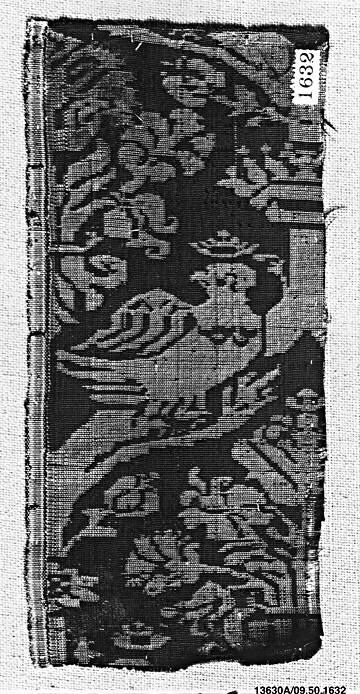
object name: piece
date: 1501-1600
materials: metal thread, silk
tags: birds